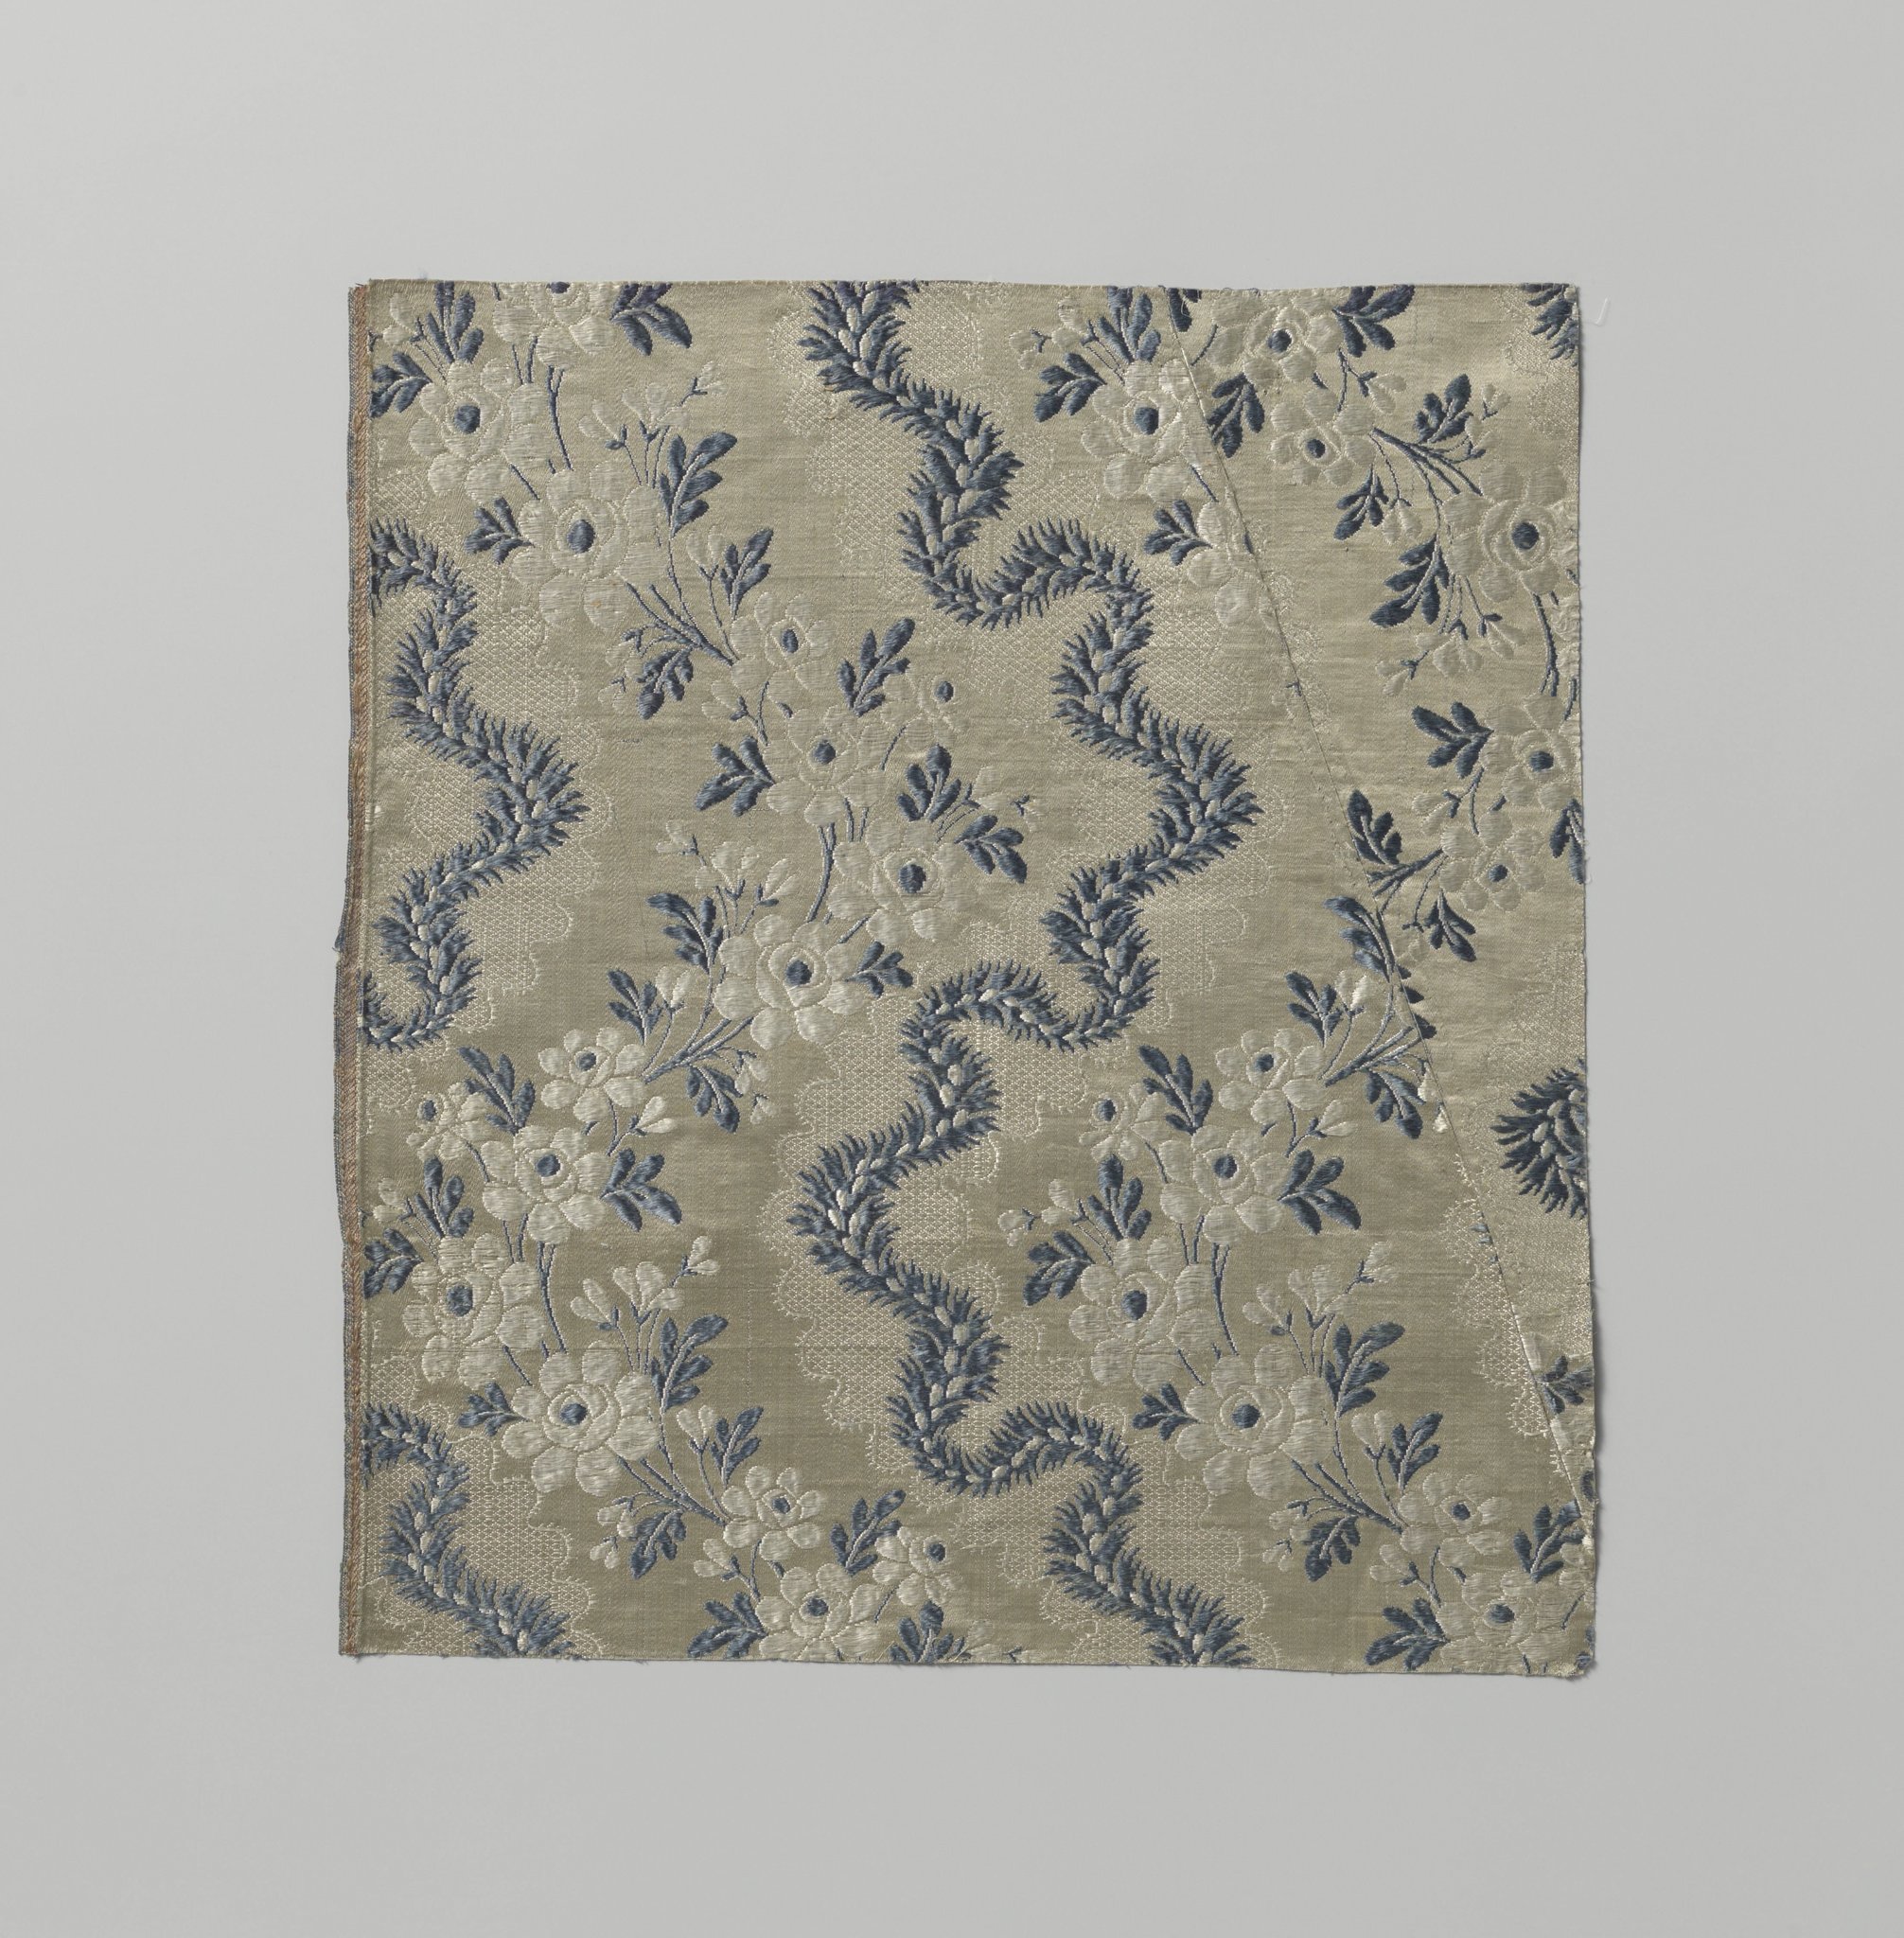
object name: zijdesatijn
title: Fragment zijdesatijn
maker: Anonymous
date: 1740-1760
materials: silk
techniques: launching, liseré, satin binding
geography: netherlands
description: Fragment zijdeweefsel met een grijze grond waarop een witte kantslinger waarbinnen een groene bladtak en waaromheen bloemranken in groen en wit. Twee aan elkaar genaaide stukken.